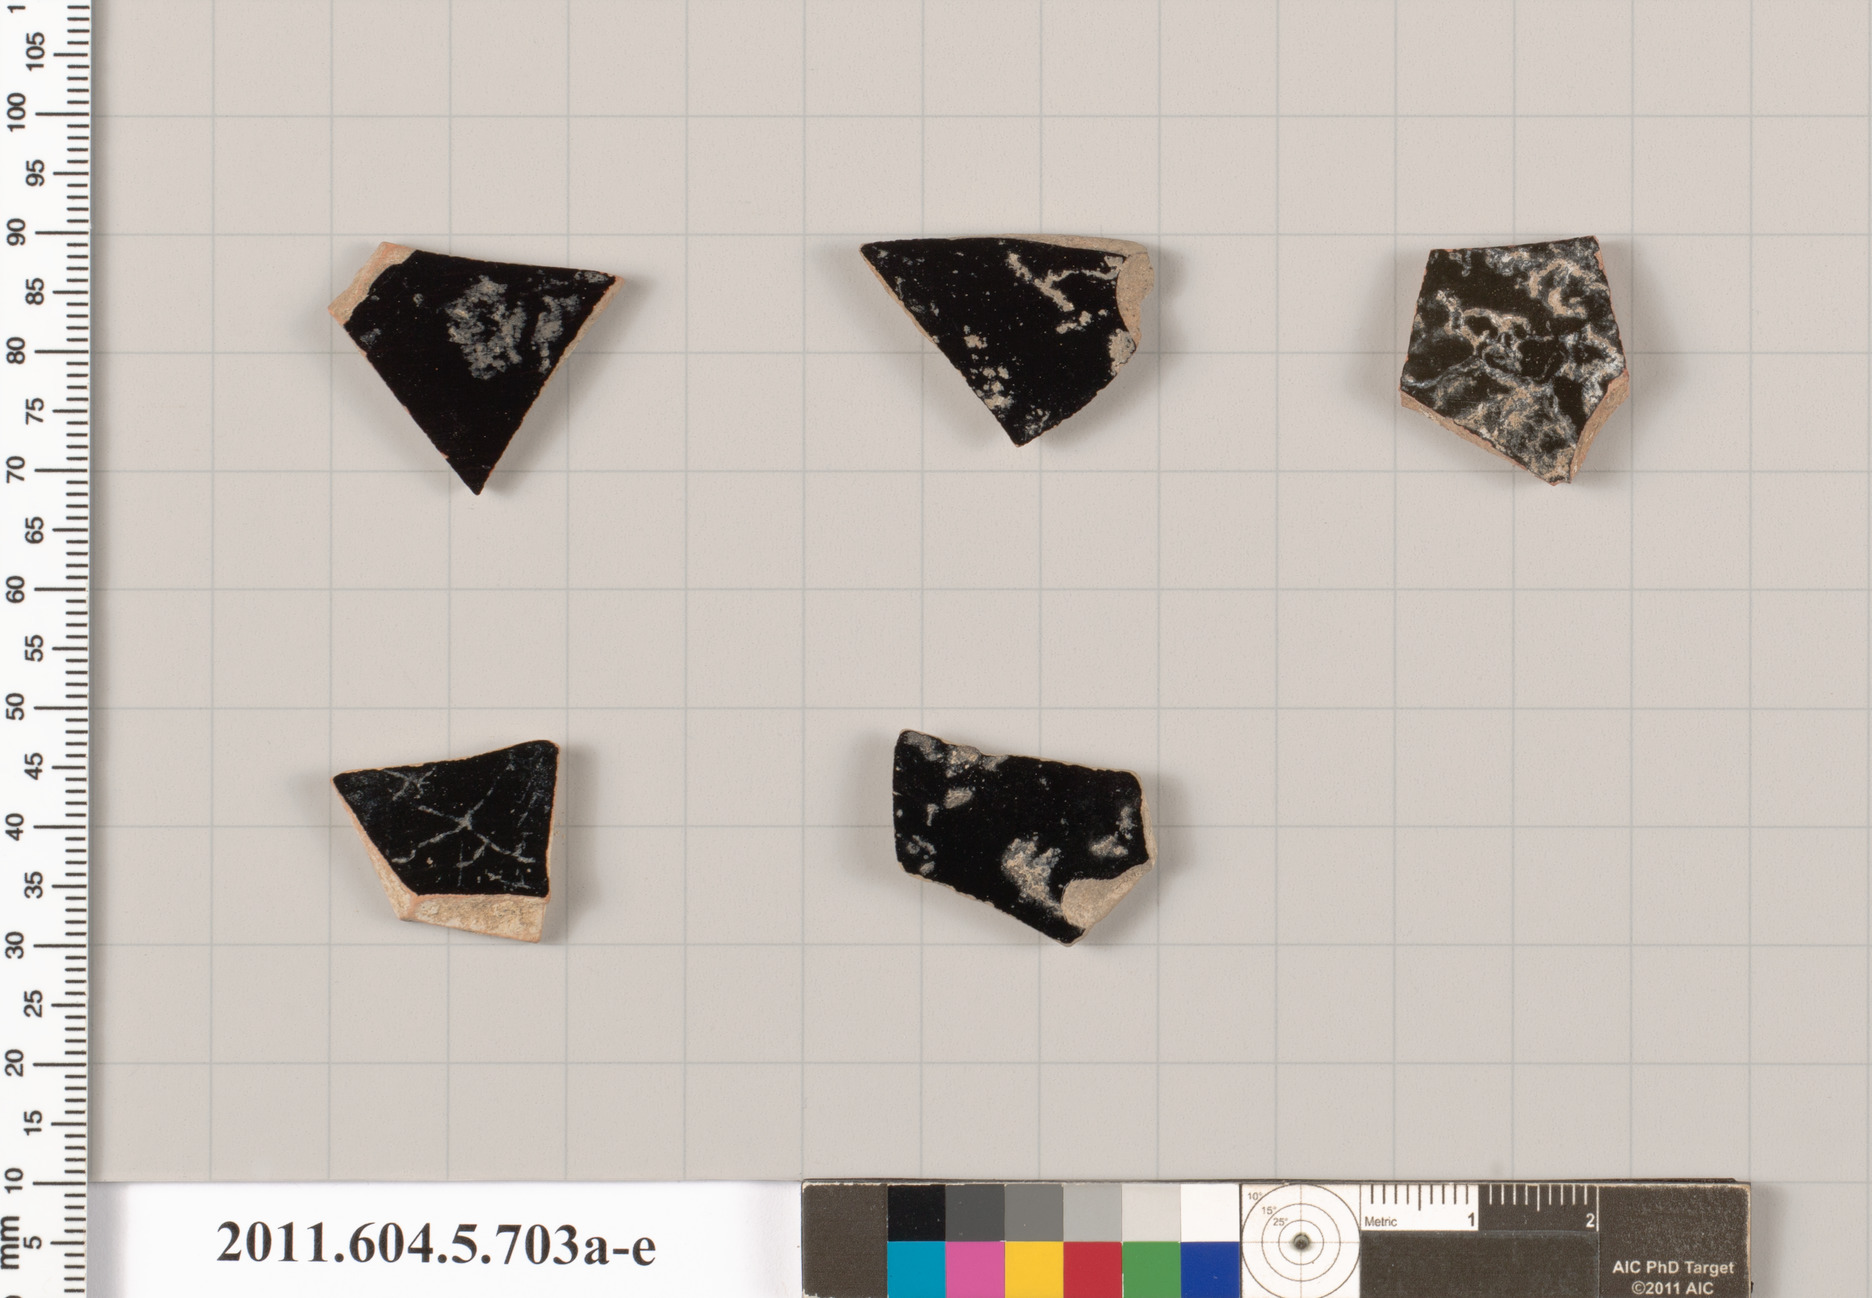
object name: kylix fragment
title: Terracotta fragments of kylikes (drinking cups)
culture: greek, attic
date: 600-401 BCE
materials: terracotta